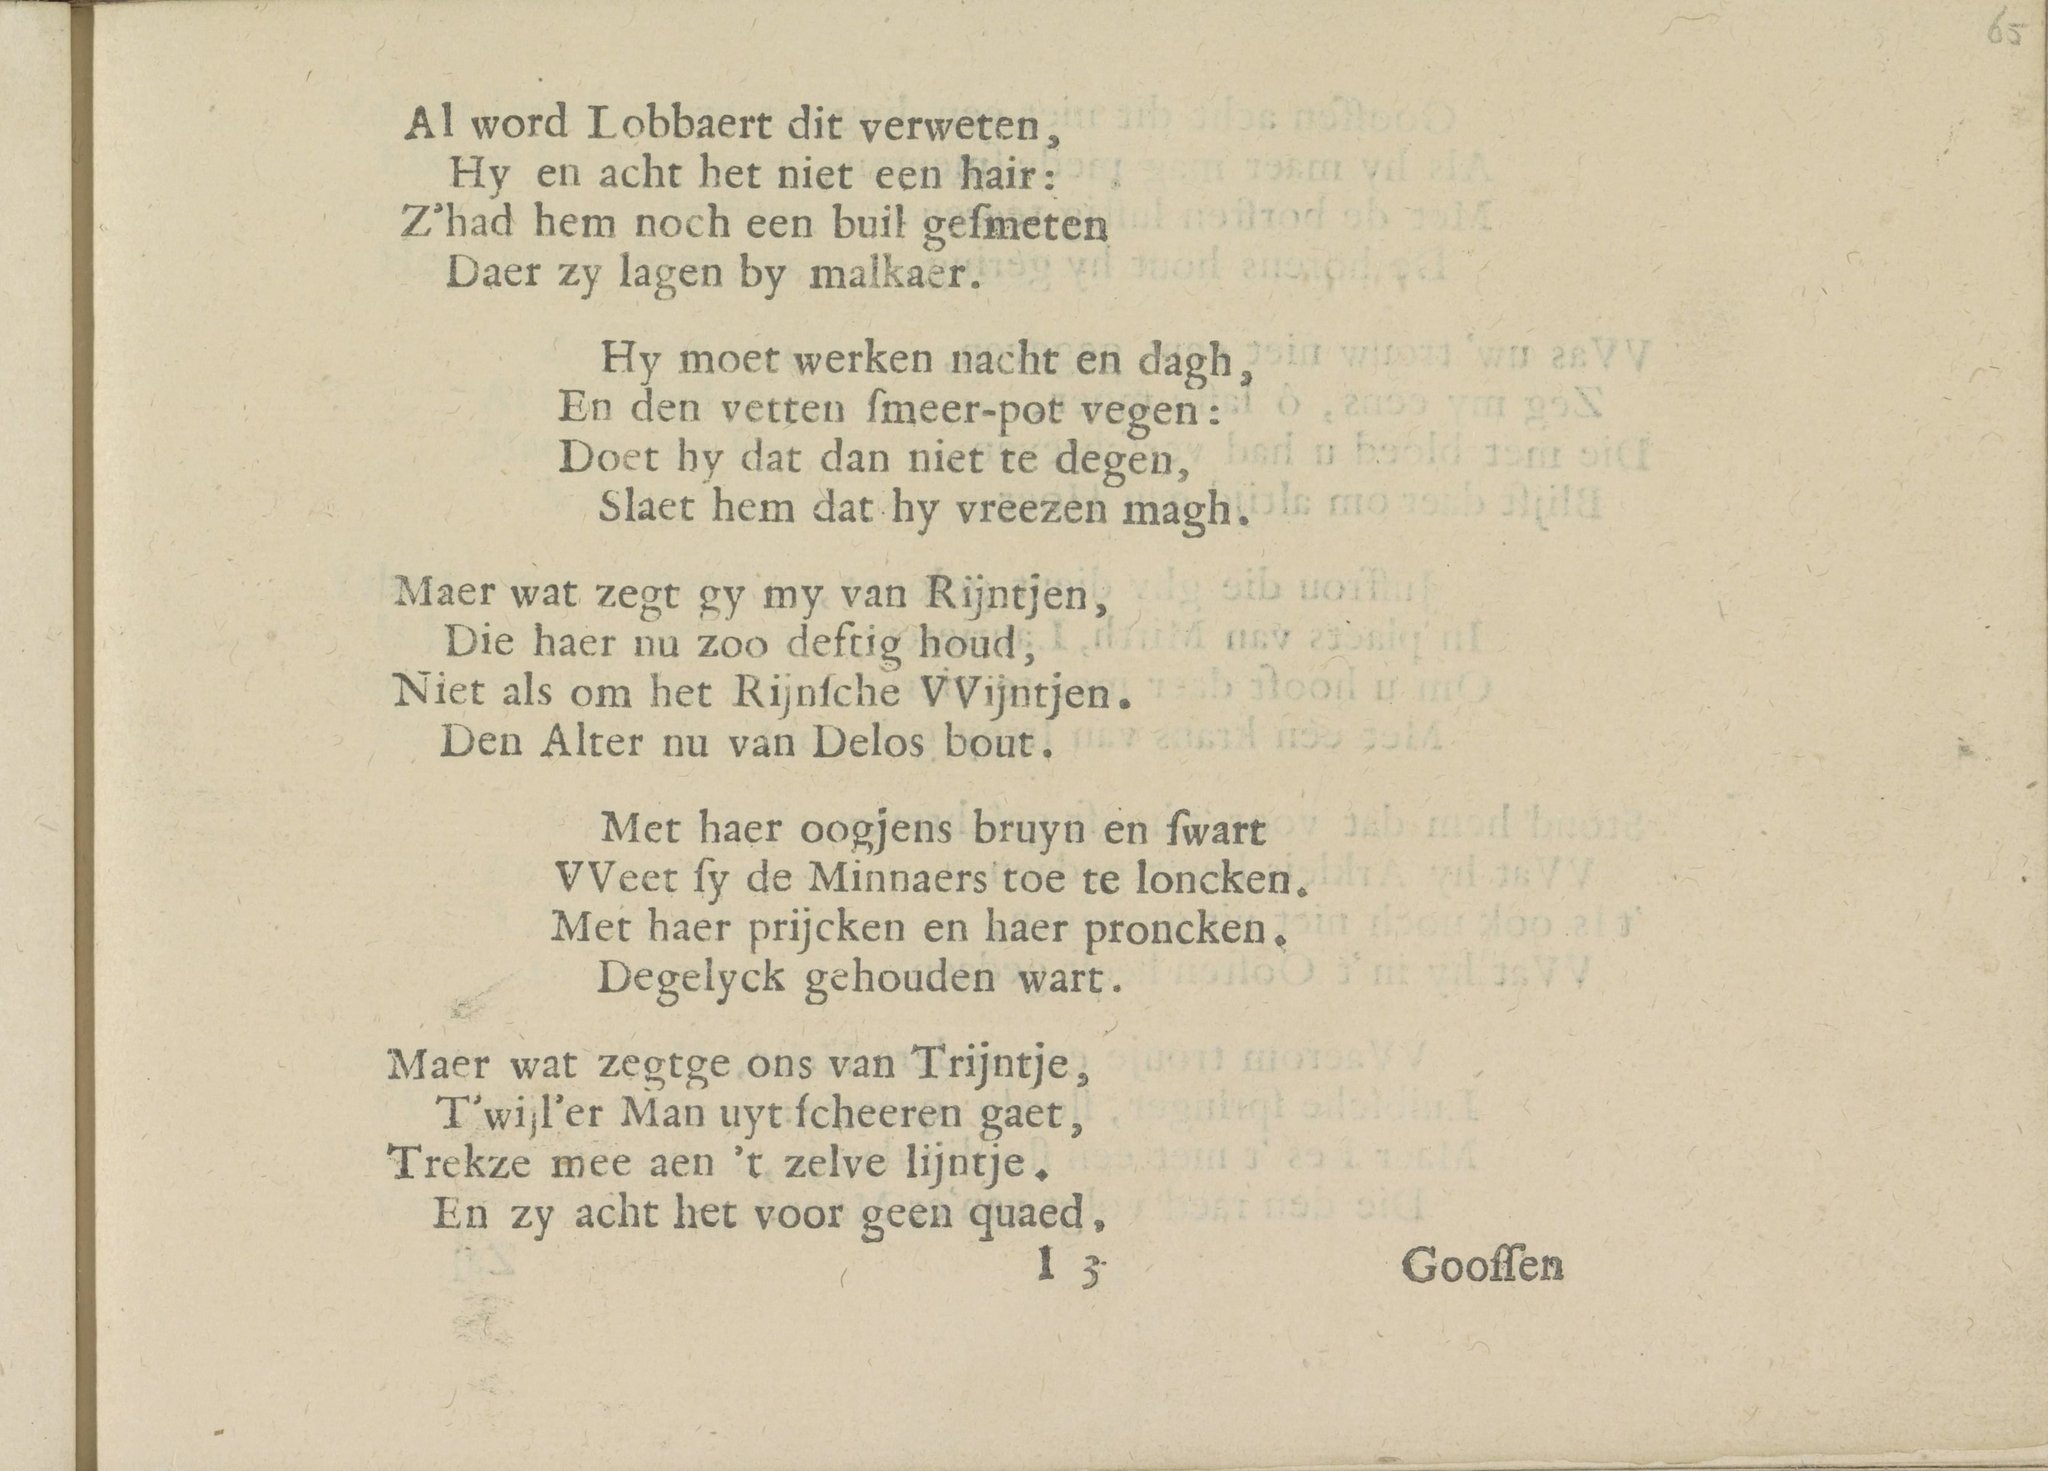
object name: album leaf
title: Der verdwaelde Boeleerders vrolick wagen-liedt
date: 1641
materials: paper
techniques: letterpress printing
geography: amsterdam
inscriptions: date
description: Wagenlied op zeven pagina's: pagina 3. Vier kwatrijnen in het Nederlands. Het blad maakt deel uit van een album.